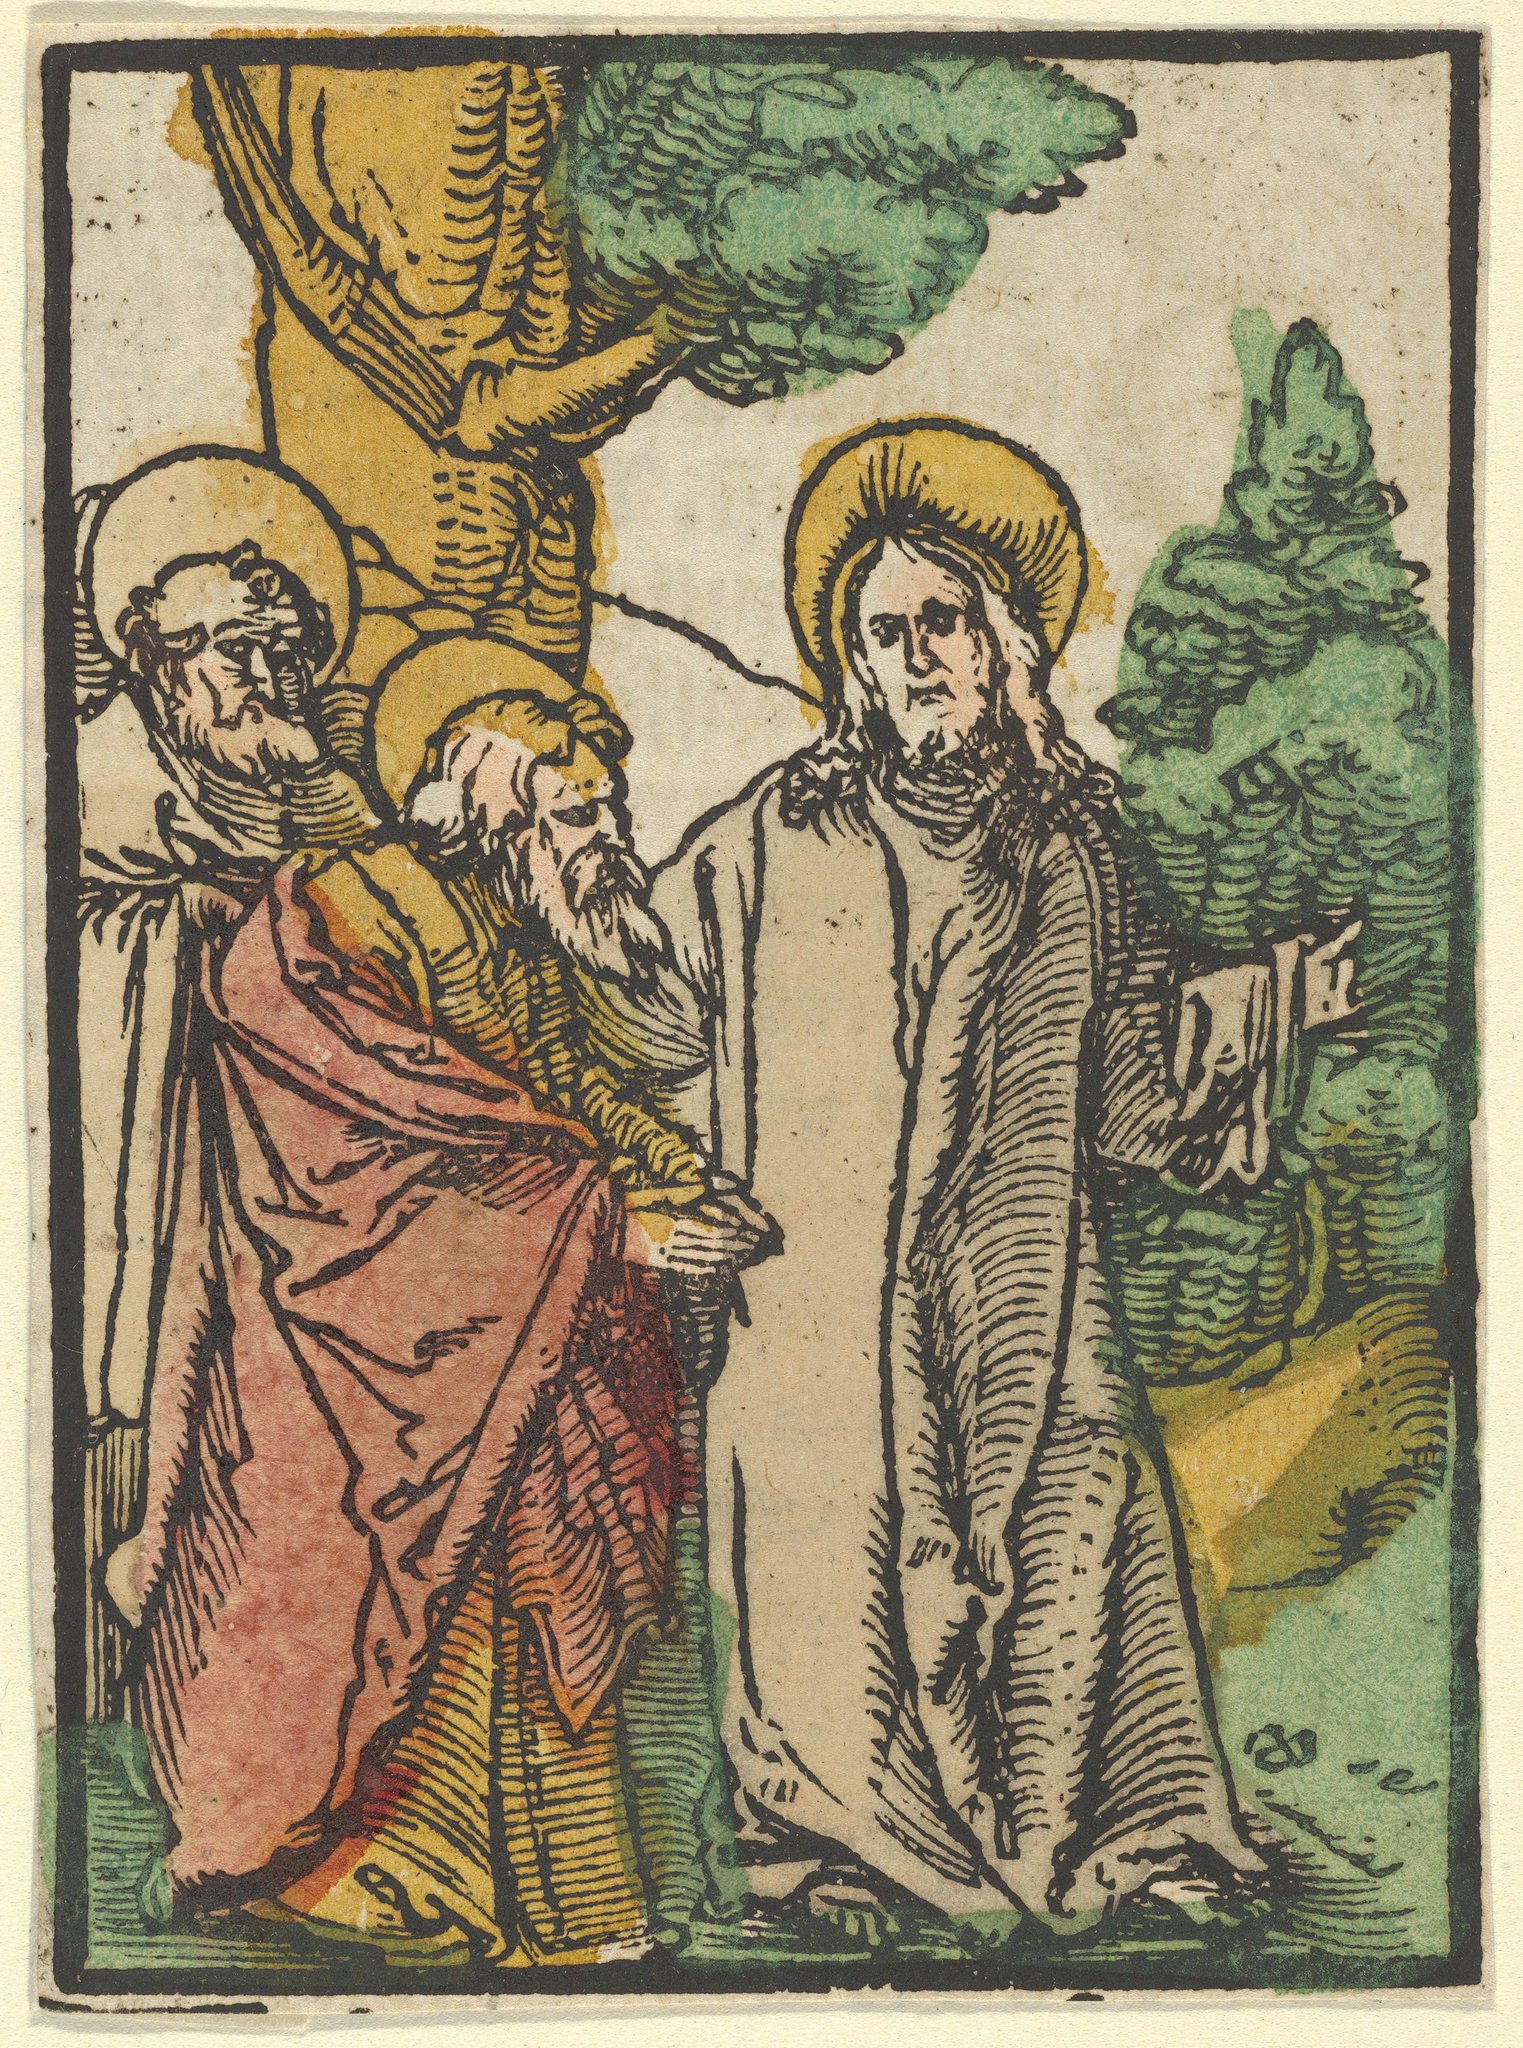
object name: print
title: Christ Talking to the Disciples, 5, from Das Plenarium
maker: hans schäufelein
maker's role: artist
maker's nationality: german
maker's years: 1480-1540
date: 1517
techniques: hand coloring, woodcut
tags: men,jesus